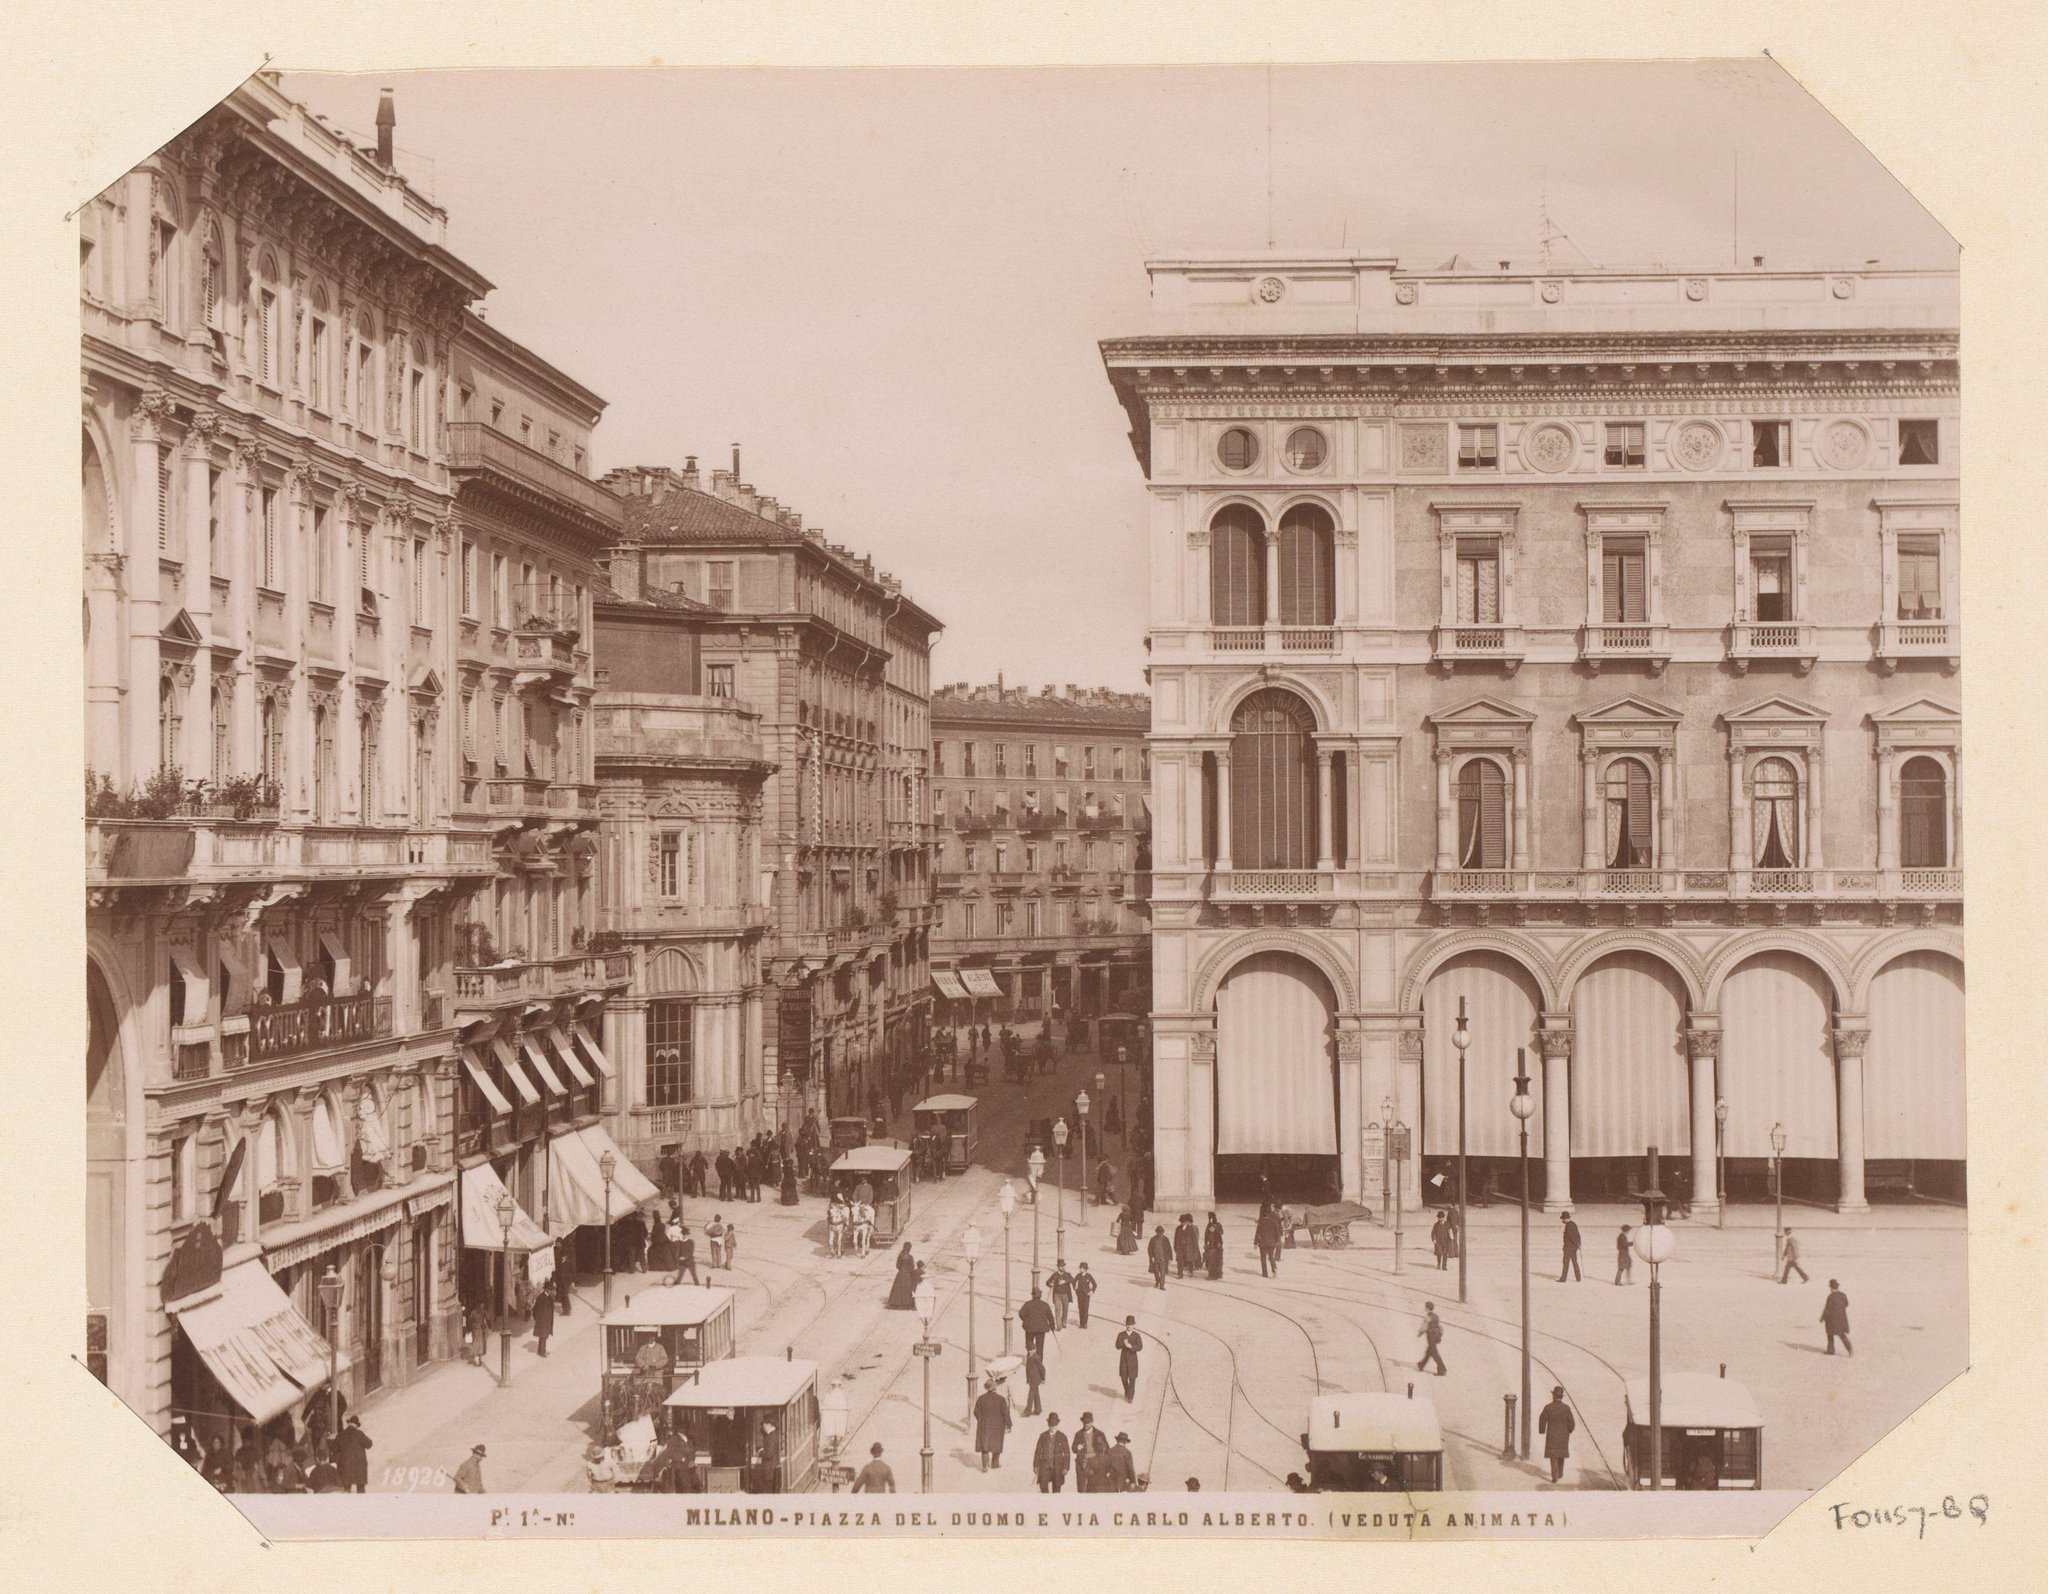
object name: photograph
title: Milano. - Piazza del Duomo e Via Carlo Alberto. (veduta animata)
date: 1885-1892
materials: photographic support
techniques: albumen print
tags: square, place, circus, etc., street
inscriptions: annotation: ‘Milaan - Piazza del Duomo’, number: ‘18928 Pe.1a.-No.’